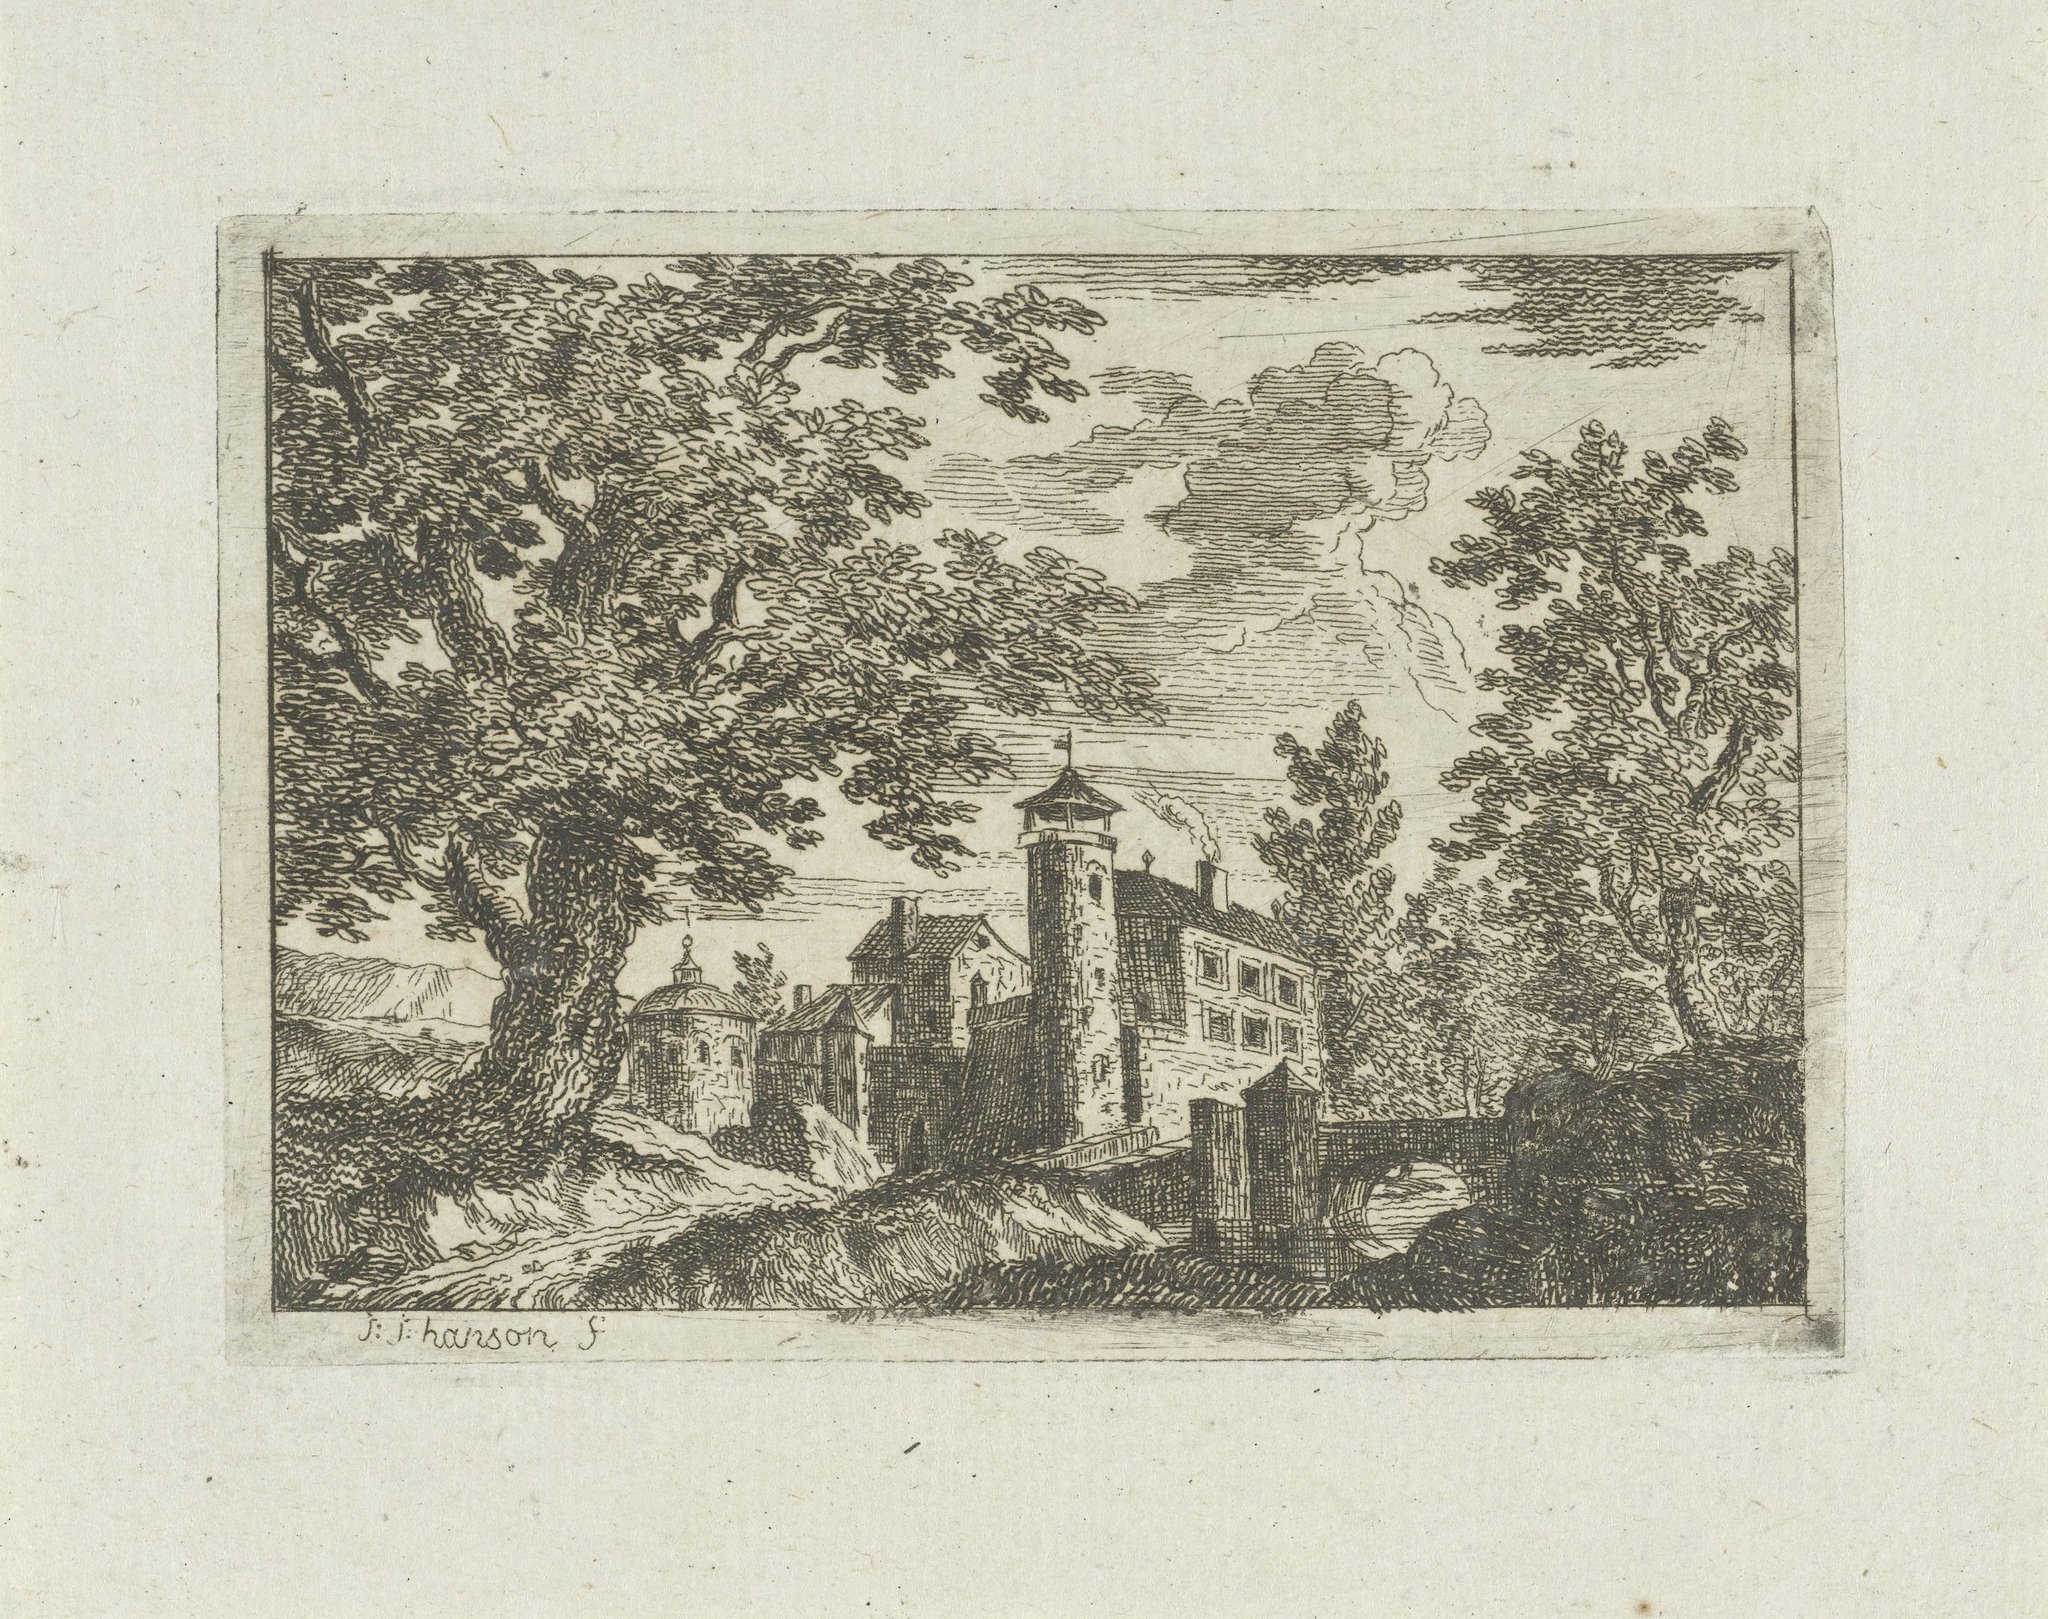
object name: print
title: Kasteel in een landschap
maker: jean joseph hanson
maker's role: painter, print maker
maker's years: 1731-1799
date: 1741-1799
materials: paper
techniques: etching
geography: southern netherlands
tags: castle, landscape with tower or castle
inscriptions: collector's mark: Lugt 2228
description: Kasteel en een stenen brug in een boomrijk landschap.